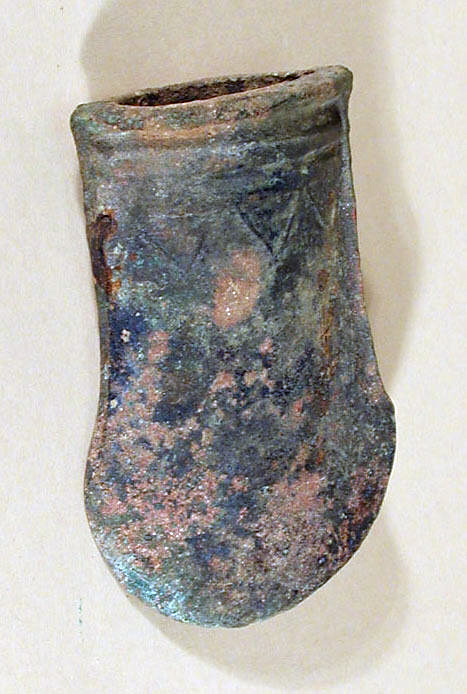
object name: axe head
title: Axe Head with Triangular Design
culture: chinese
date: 1000-1 BCE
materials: bronze